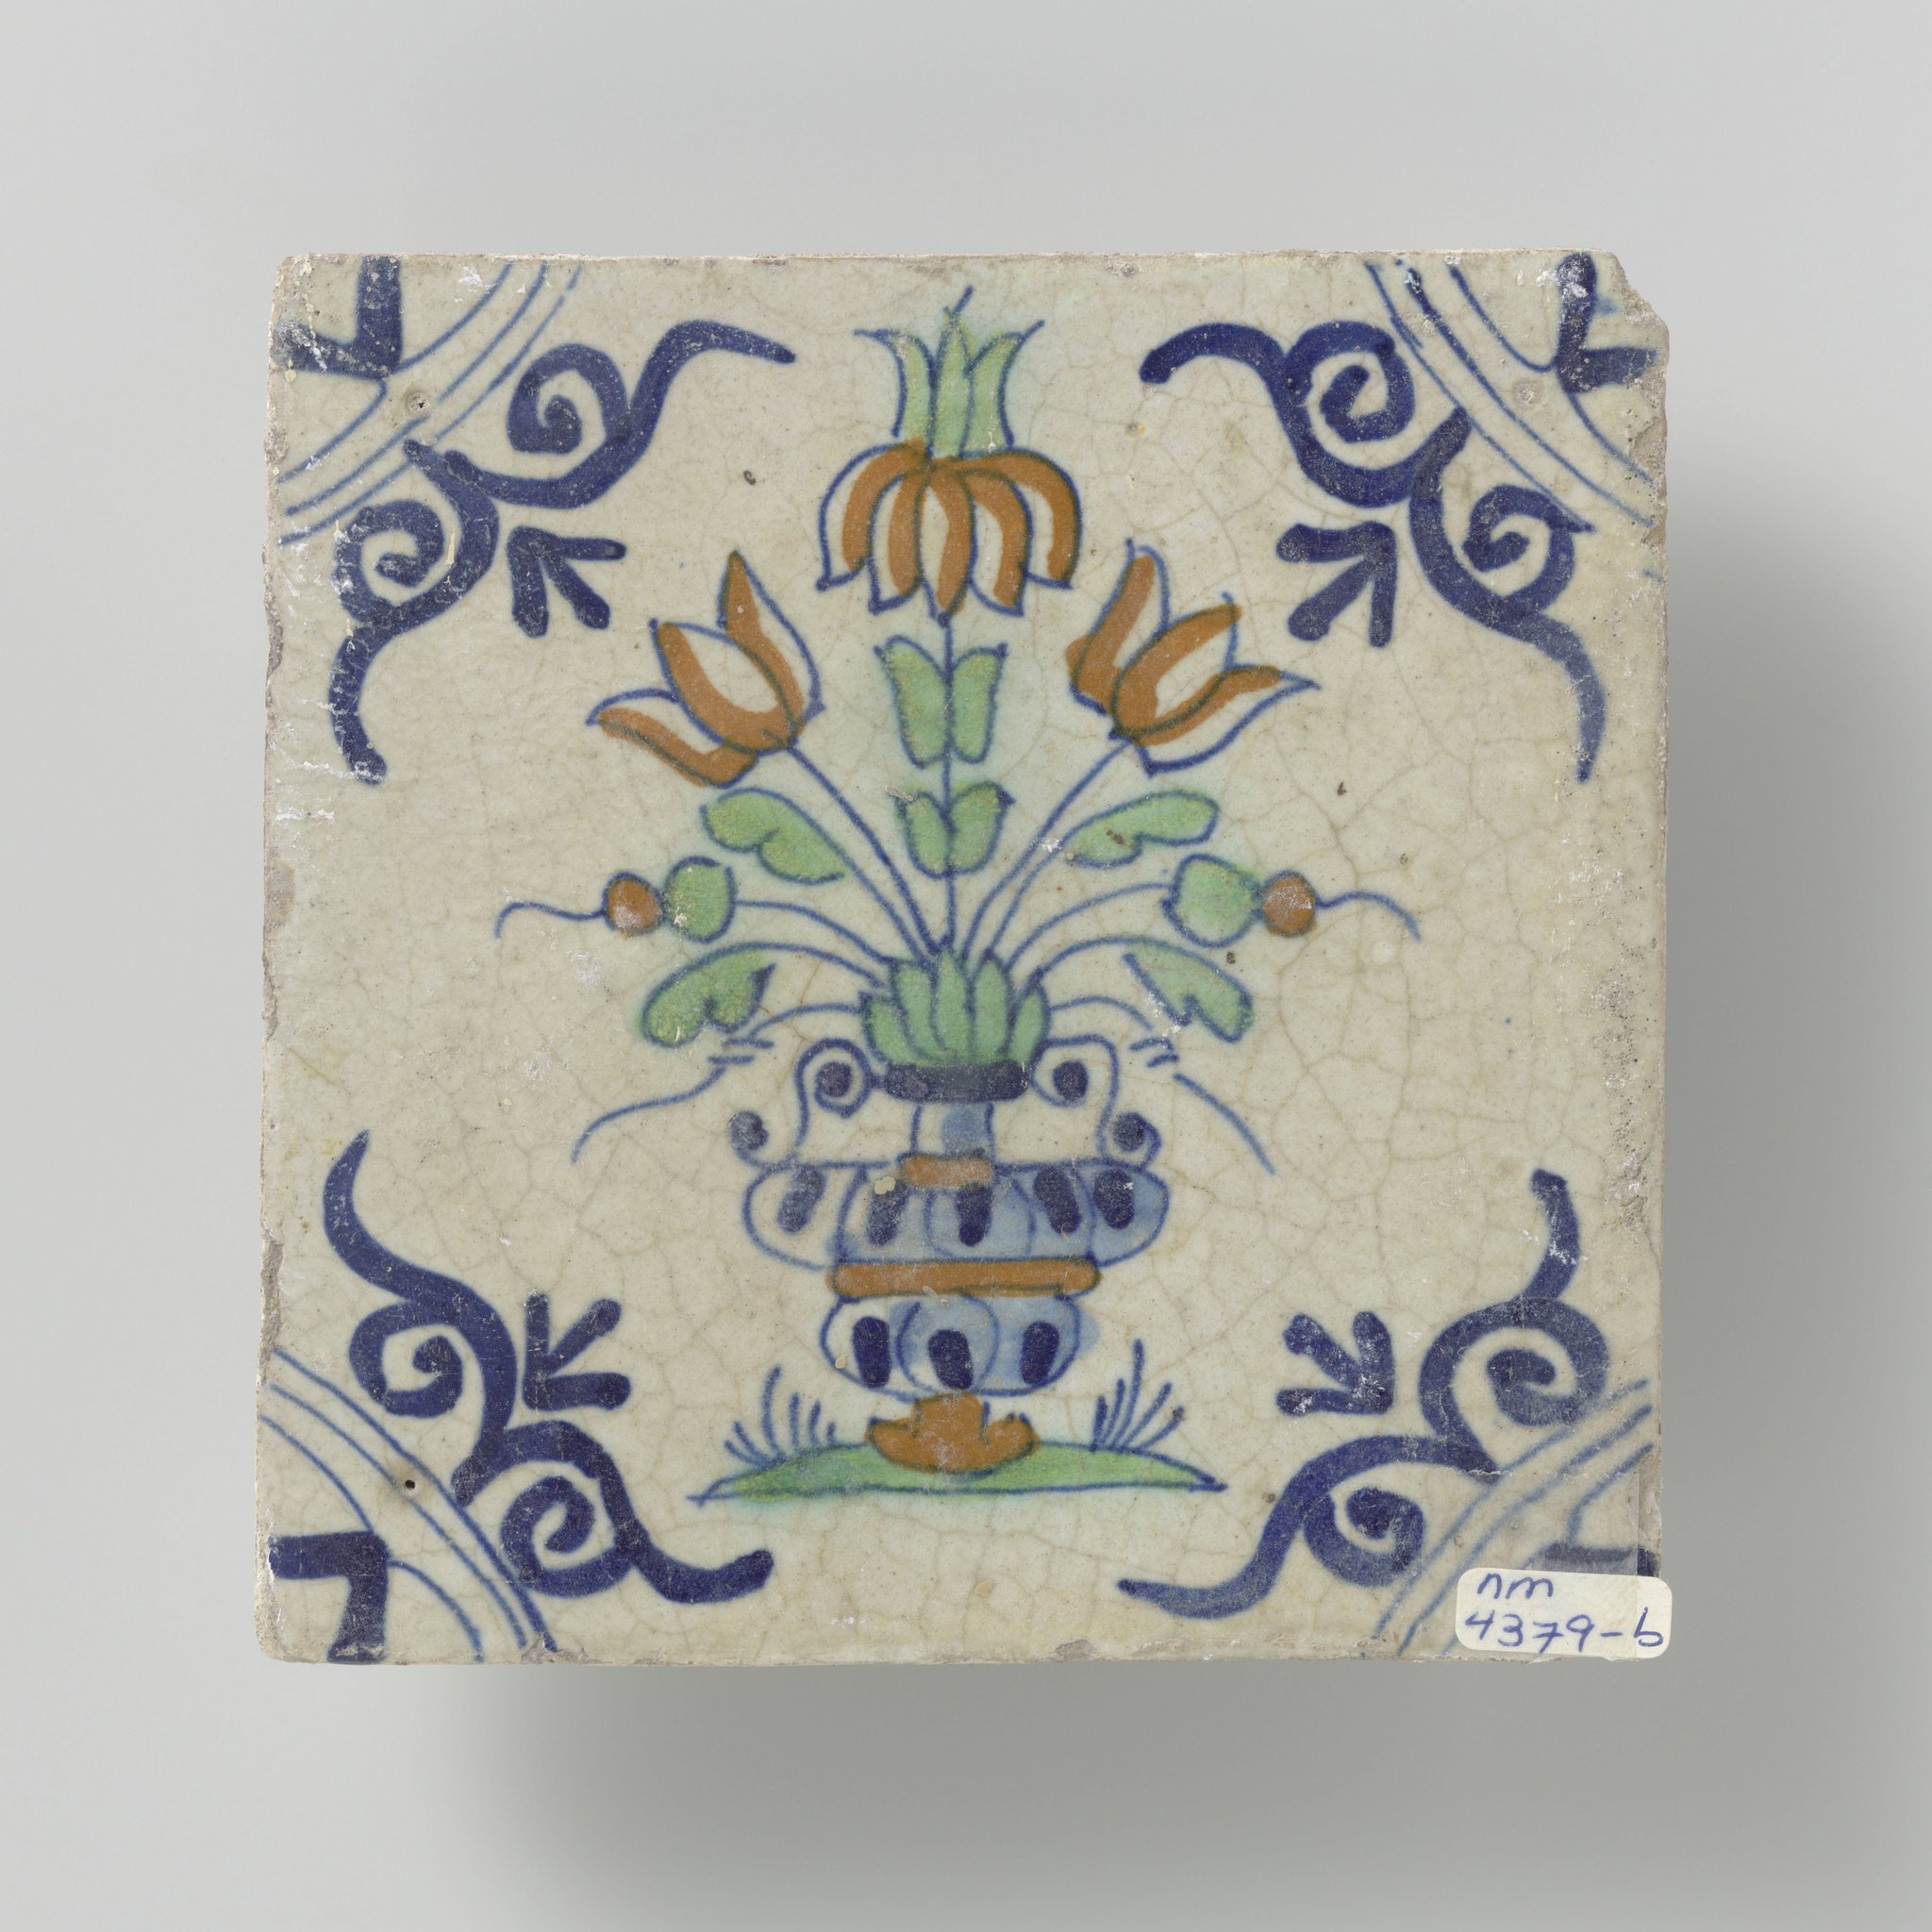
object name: pompadourtegel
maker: Anonymous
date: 1580-1625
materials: earthenware, glaze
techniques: maiolica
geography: netherlands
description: Pompadourtegel met een veelkleurige (blauw, groen en oranje) bloempot. In de hoeken, ornament in vultechniek.